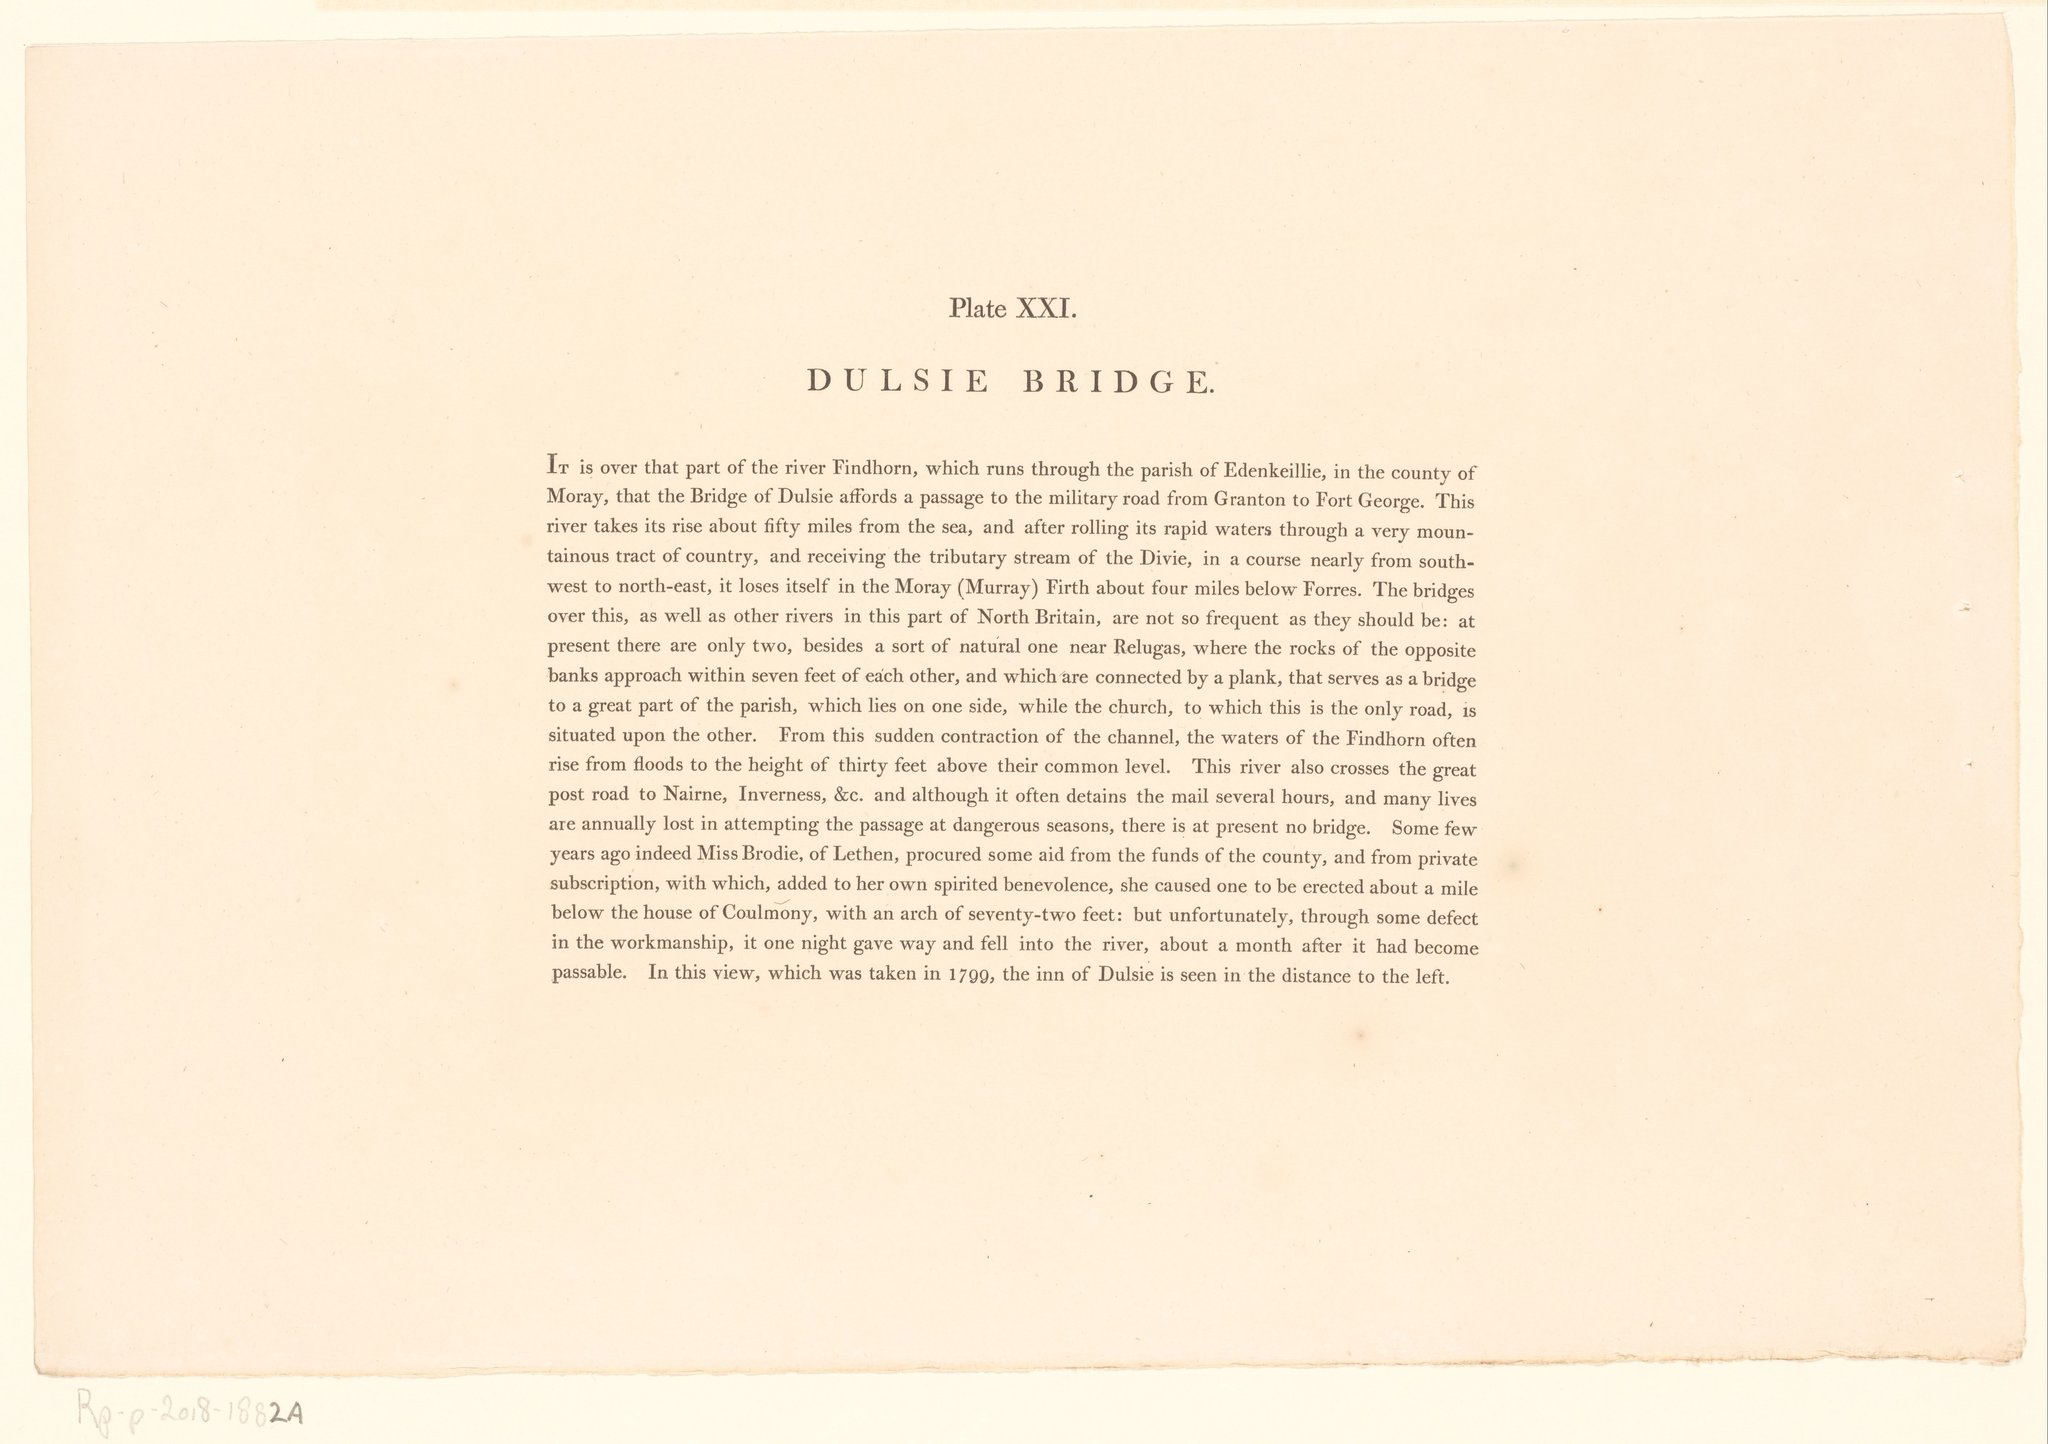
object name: text sheet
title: Plate XXI. Dulsie Bridge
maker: william miller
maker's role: bookseller, printer, publisher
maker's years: 1769-1844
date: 1801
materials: paper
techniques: letterpress printing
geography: london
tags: schotland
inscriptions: collector's mark: Lugt 2228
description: Tekstblad gebruikt in: Scotia Depicta; or the antiquities, castles, public buildings, noblemen (...). Londen: William Miller, 1801.